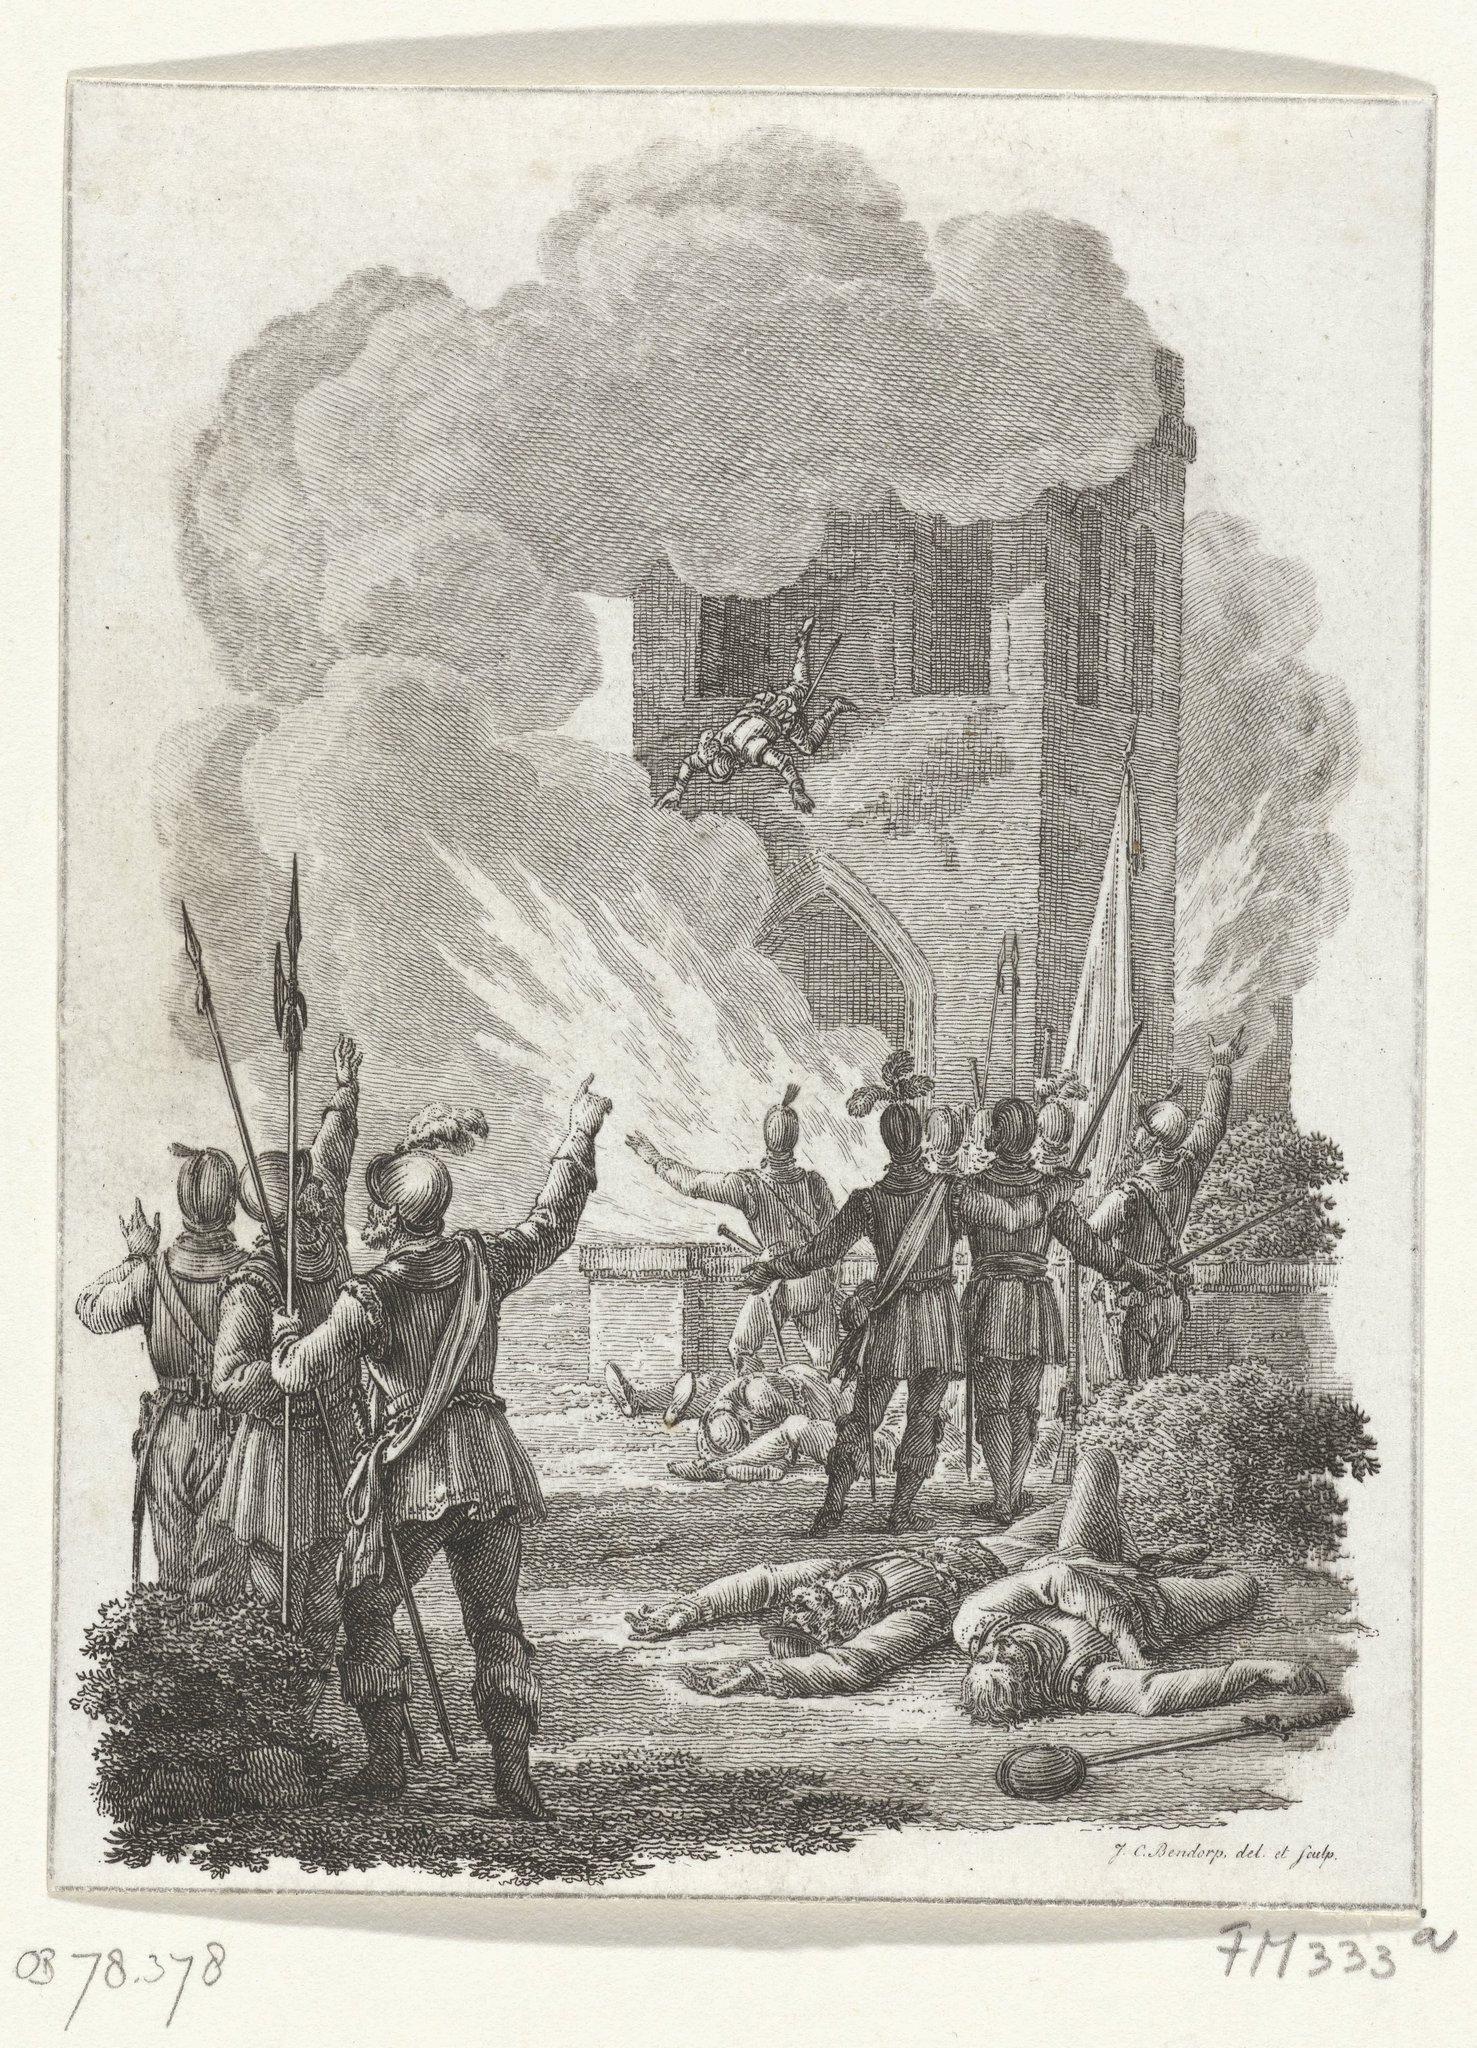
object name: print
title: Jan van Schaffelaar springt van de toren, 1482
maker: johannes christiaan bendorp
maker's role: print maker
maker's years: 1766-1849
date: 1776-1849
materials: paper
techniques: etching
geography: netherlands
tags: self-sacrifice, death in the service of a higher purpose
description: Jan van Schaffelaar springt (voorover) van de toren van Barneveld, 16 juli 1482.